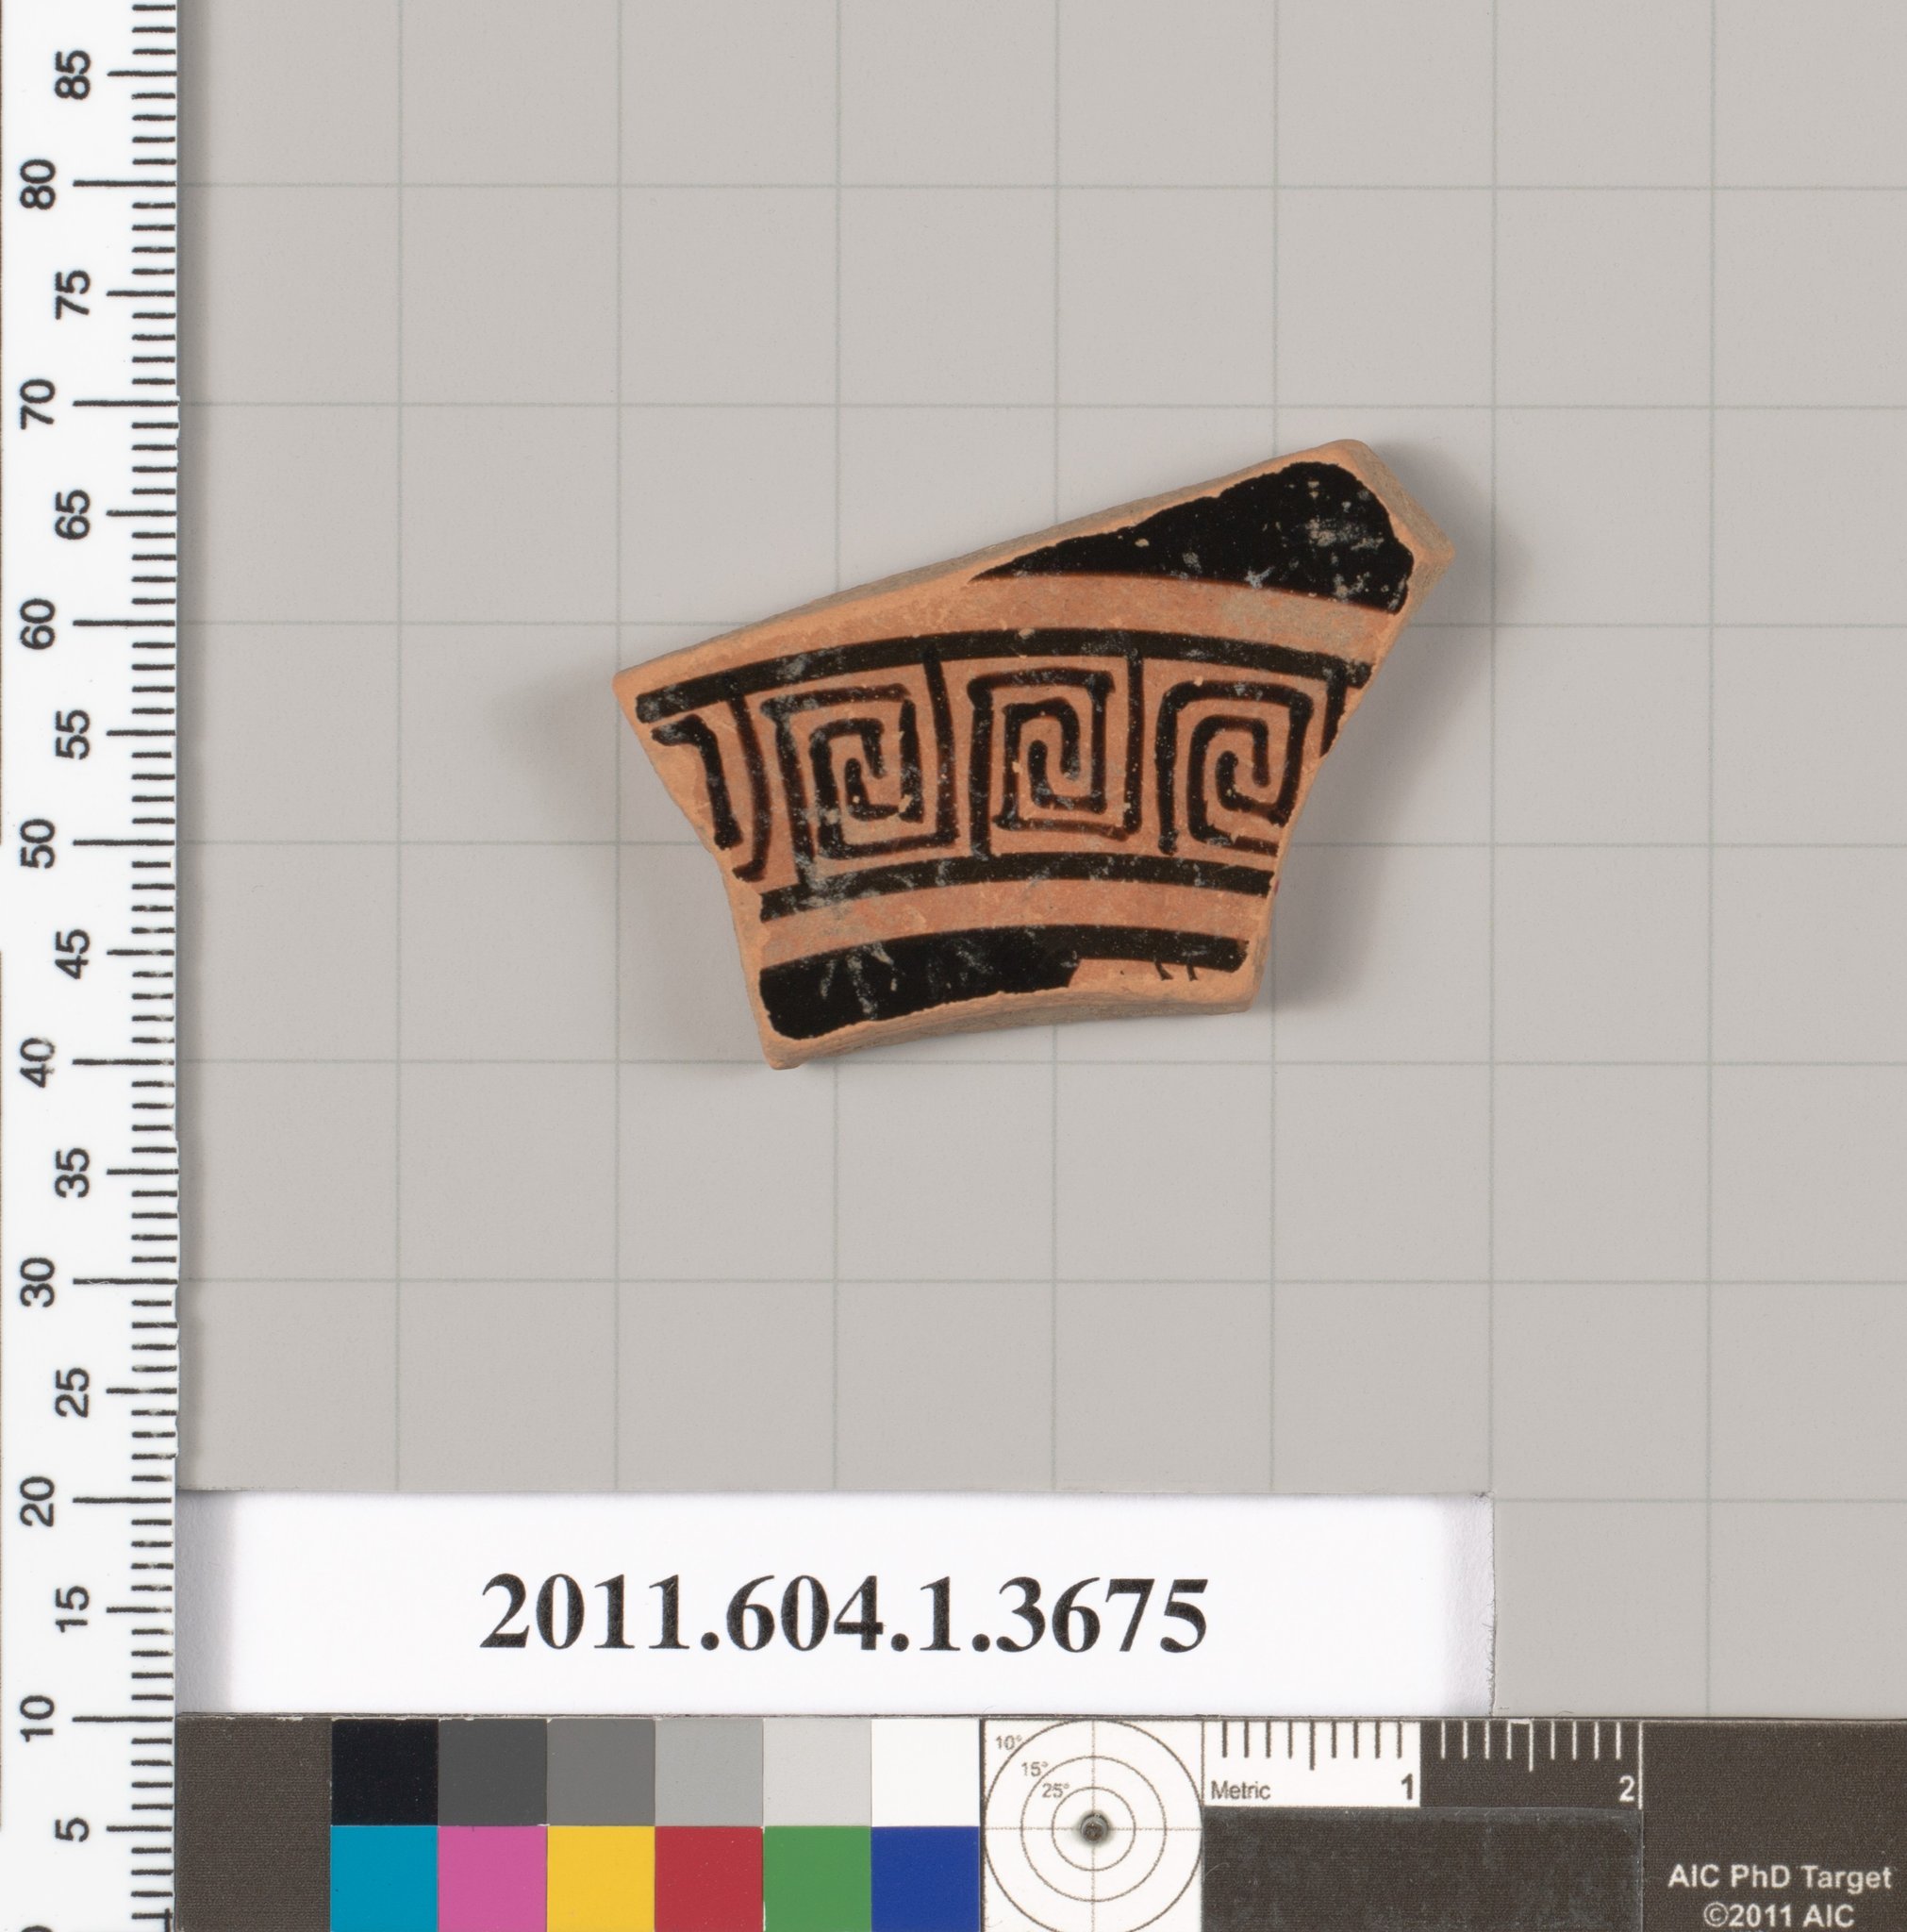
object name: kylix fragment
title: Terracotta fragment of a kylix (drinking cup)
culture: greek, attic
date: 475-451 BCE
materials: terracotta